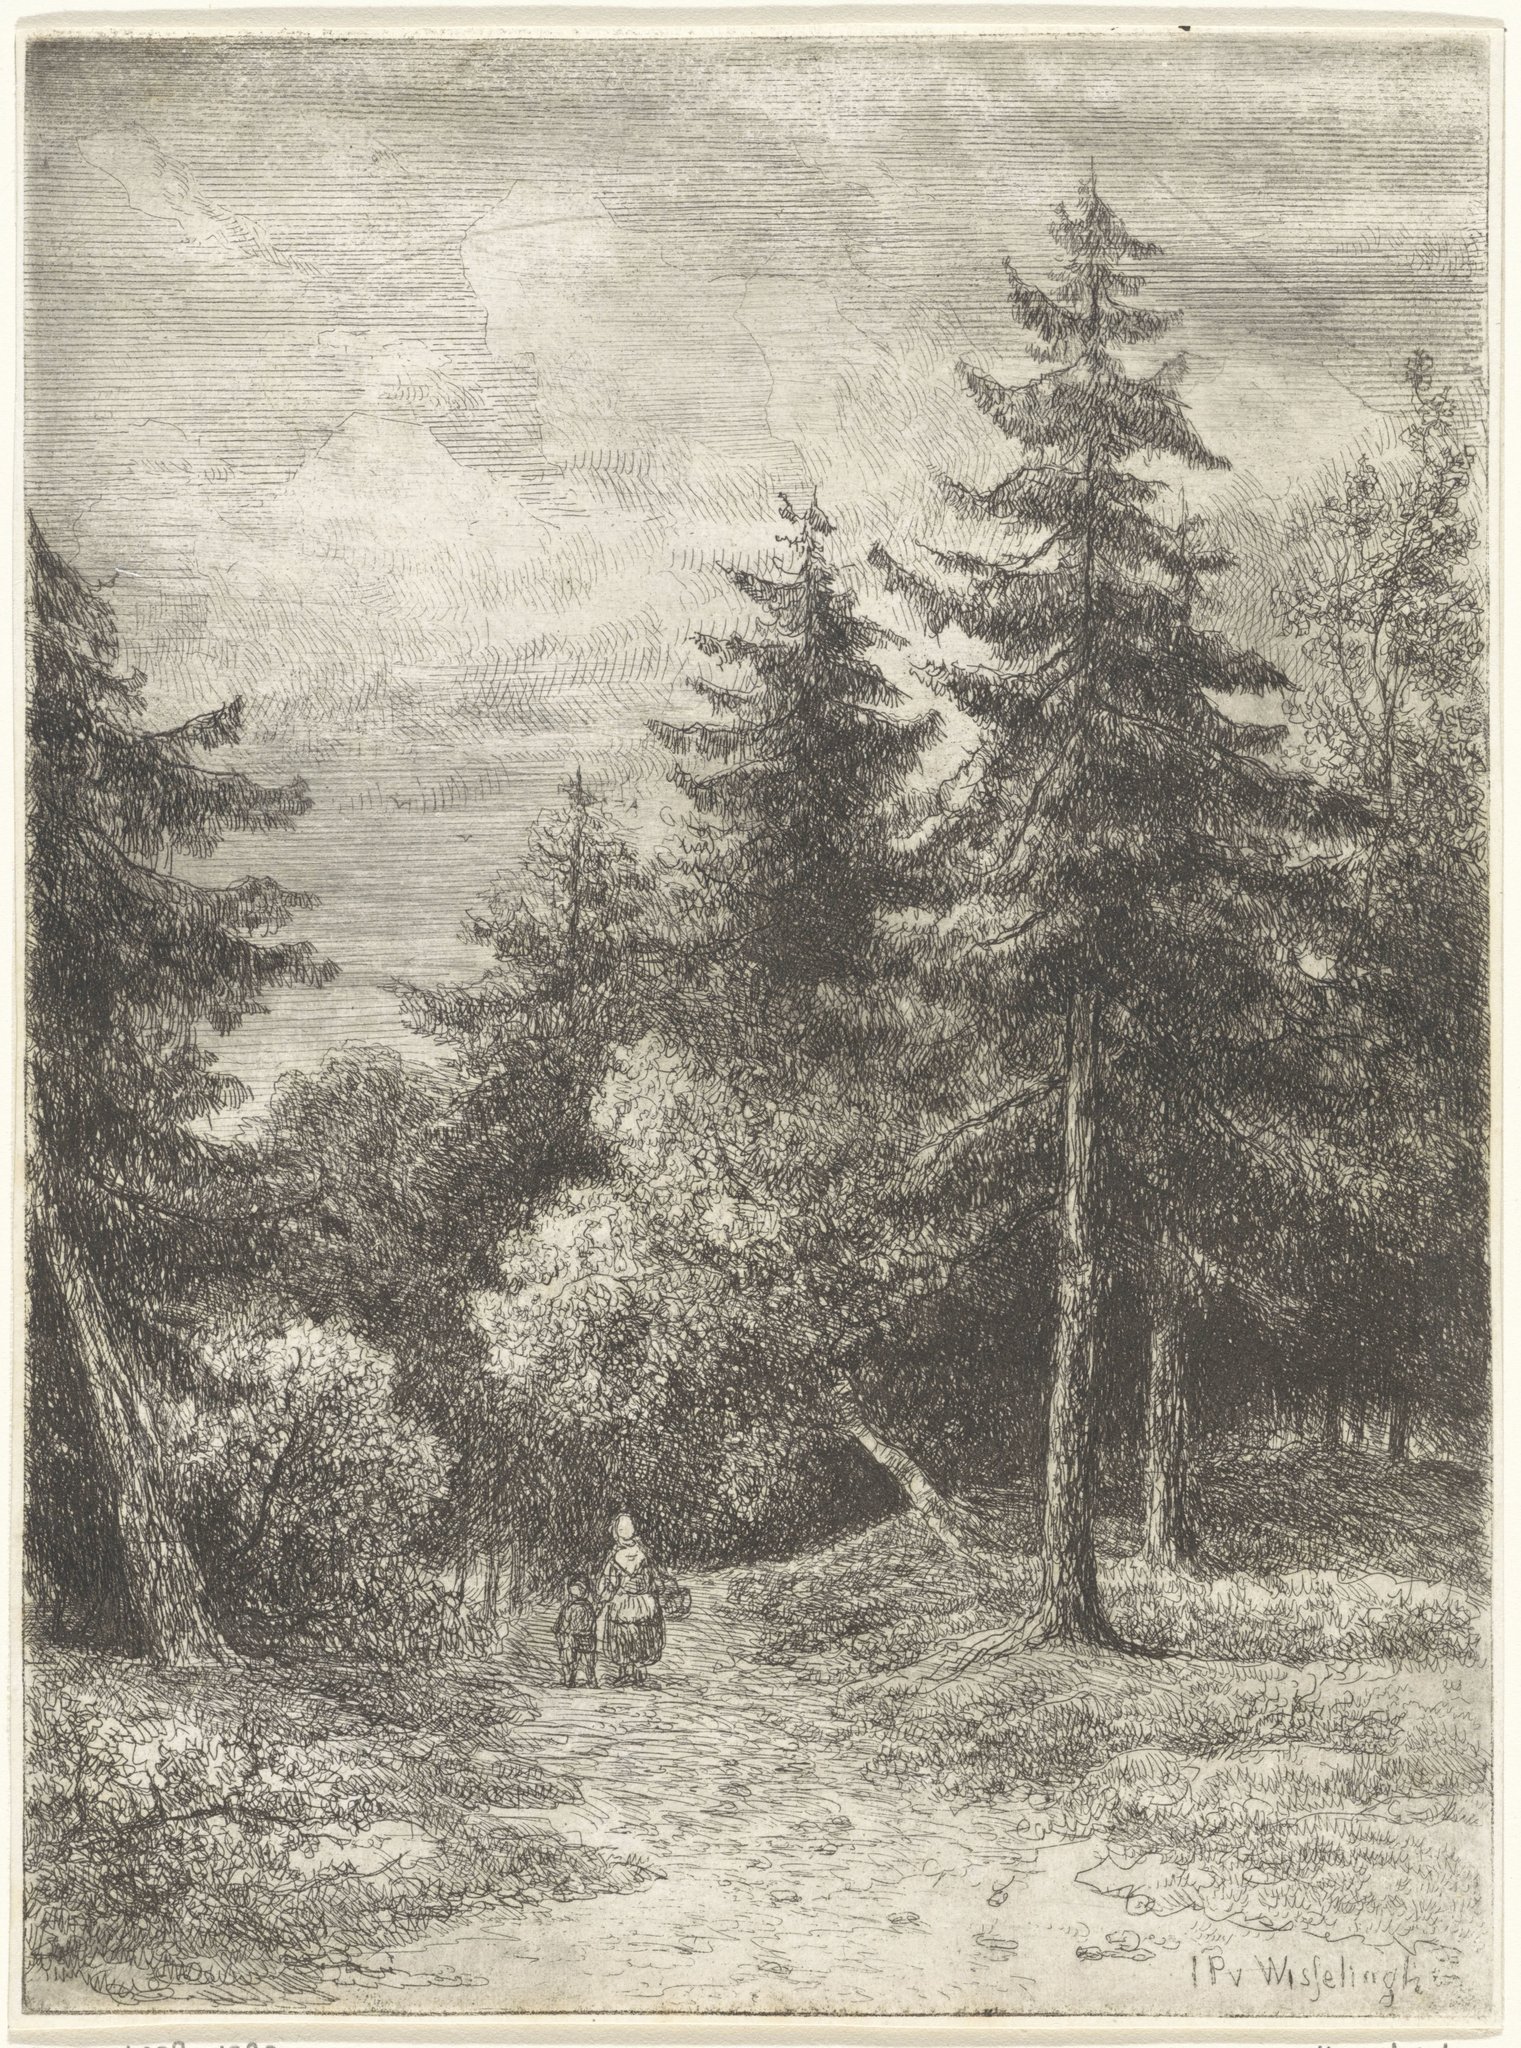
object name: print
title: Bosgezicht met vrouw en kind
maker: johannes pieter van wisselingh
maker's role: draughtsman, painter, print maker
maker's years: 1812-1899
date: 1830-1878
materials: paper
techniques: etching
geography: netherlands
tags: forest path or lane, trees: fir, mother and child(ren), woman and child(ren) (family group)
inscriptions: collector's mark: Lugt 2760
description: Gezicht op een bos met overwegend naaldbomen. In het midden een vrouw met een kind op een bospad.